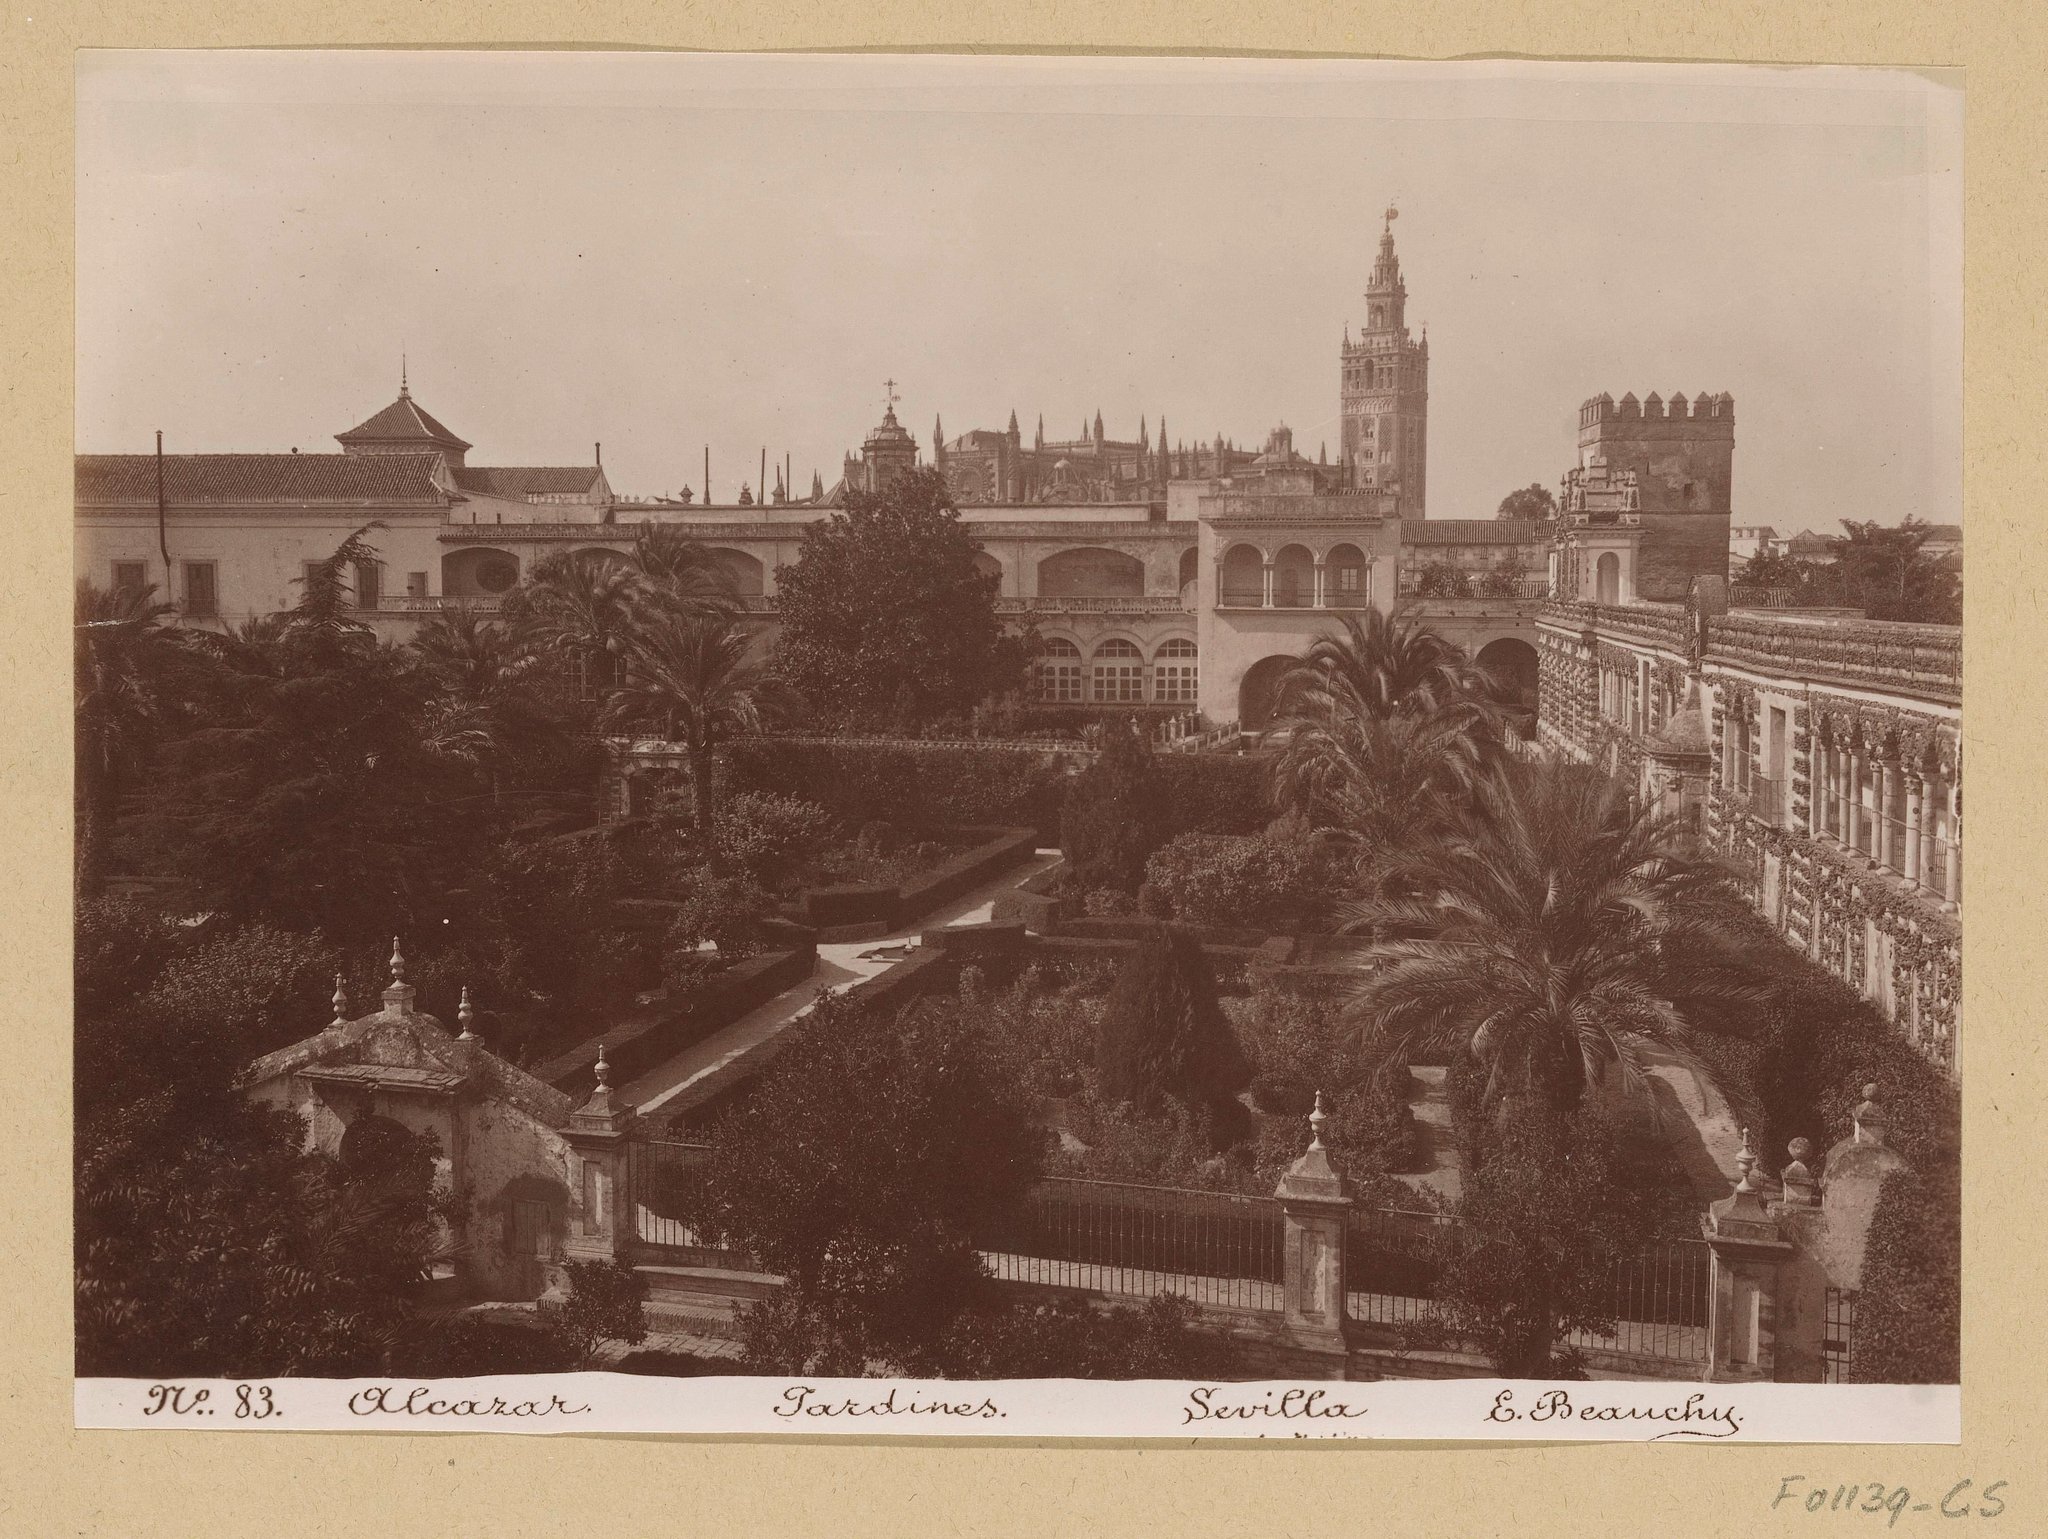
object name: photograph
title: Alcazar Jardines Sevilla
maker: emilio beauchy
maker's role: fotograaf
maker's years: 1847-1928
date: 1880-1905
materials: paper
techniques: albumen print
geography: sevilla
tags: garden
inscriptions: number: ‘No 83.’